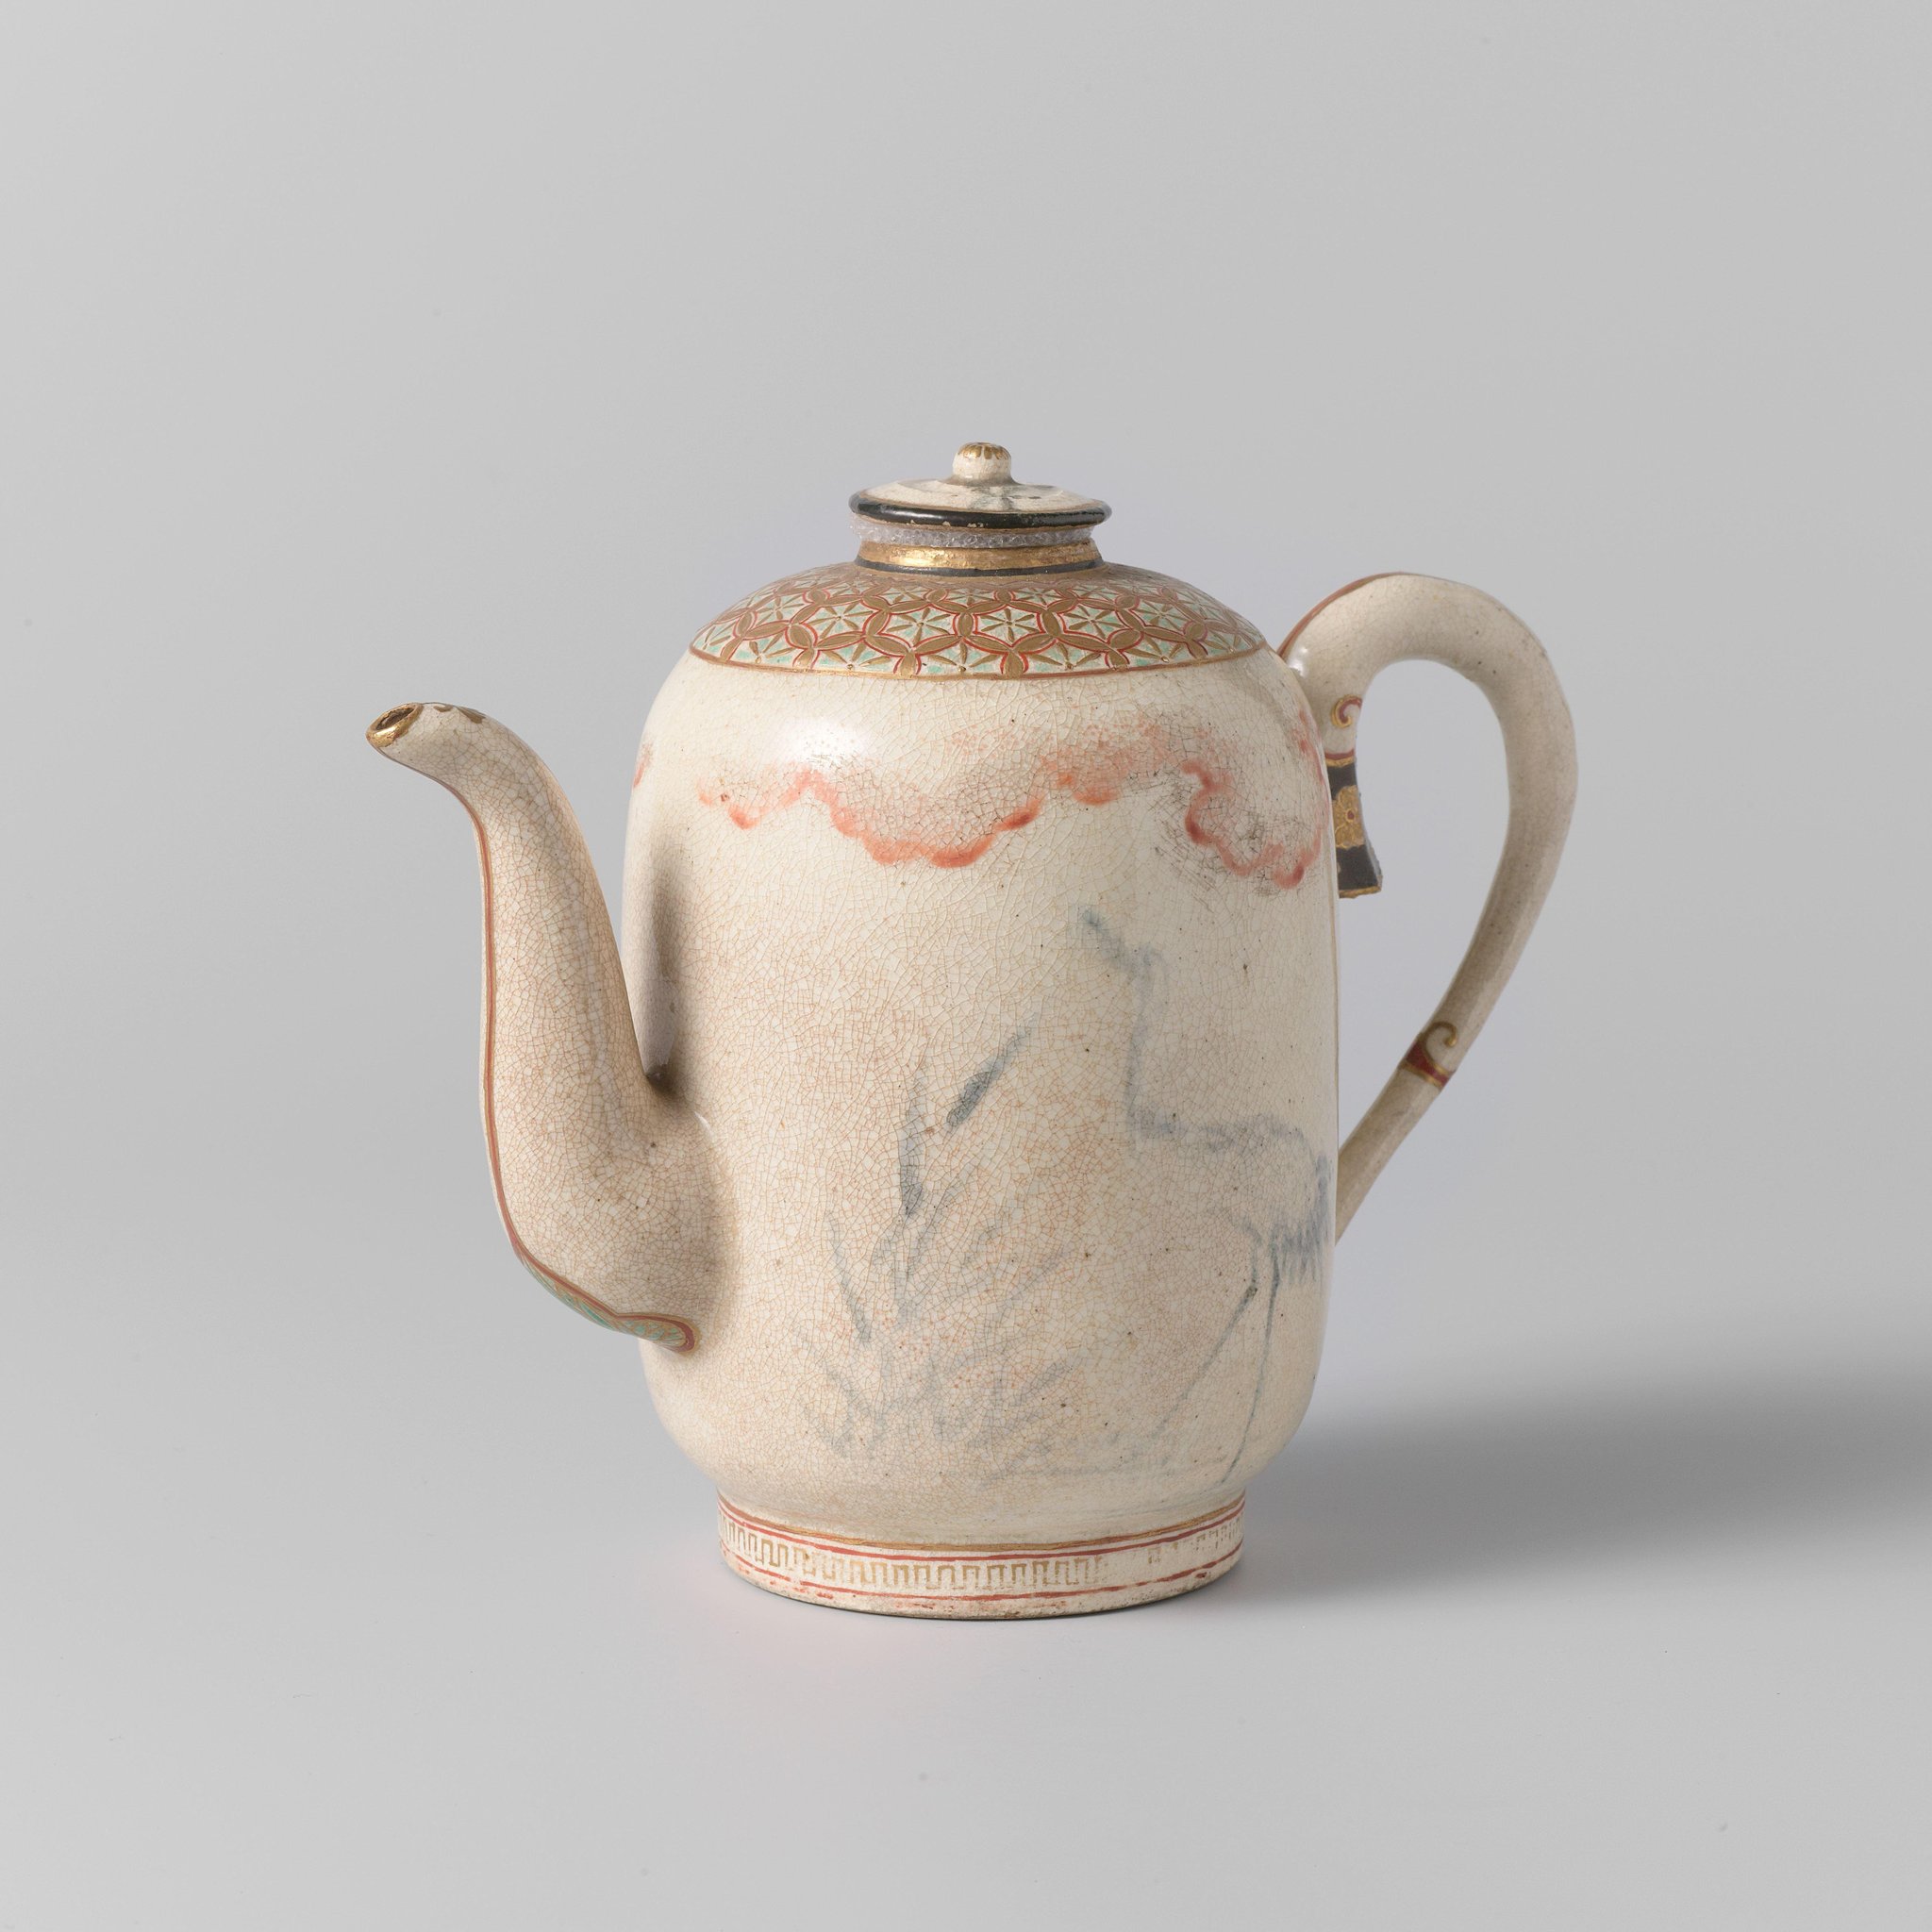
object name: teapot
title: Tea pot with crane, egret and diaper patterns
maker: Anonymous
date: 1800-1899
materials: cobalt, glaze, gold, paint, stoneware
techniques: firing, gilding, turning, vitrification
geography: kyoto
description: Versiering in email en onderglazuurblauw.